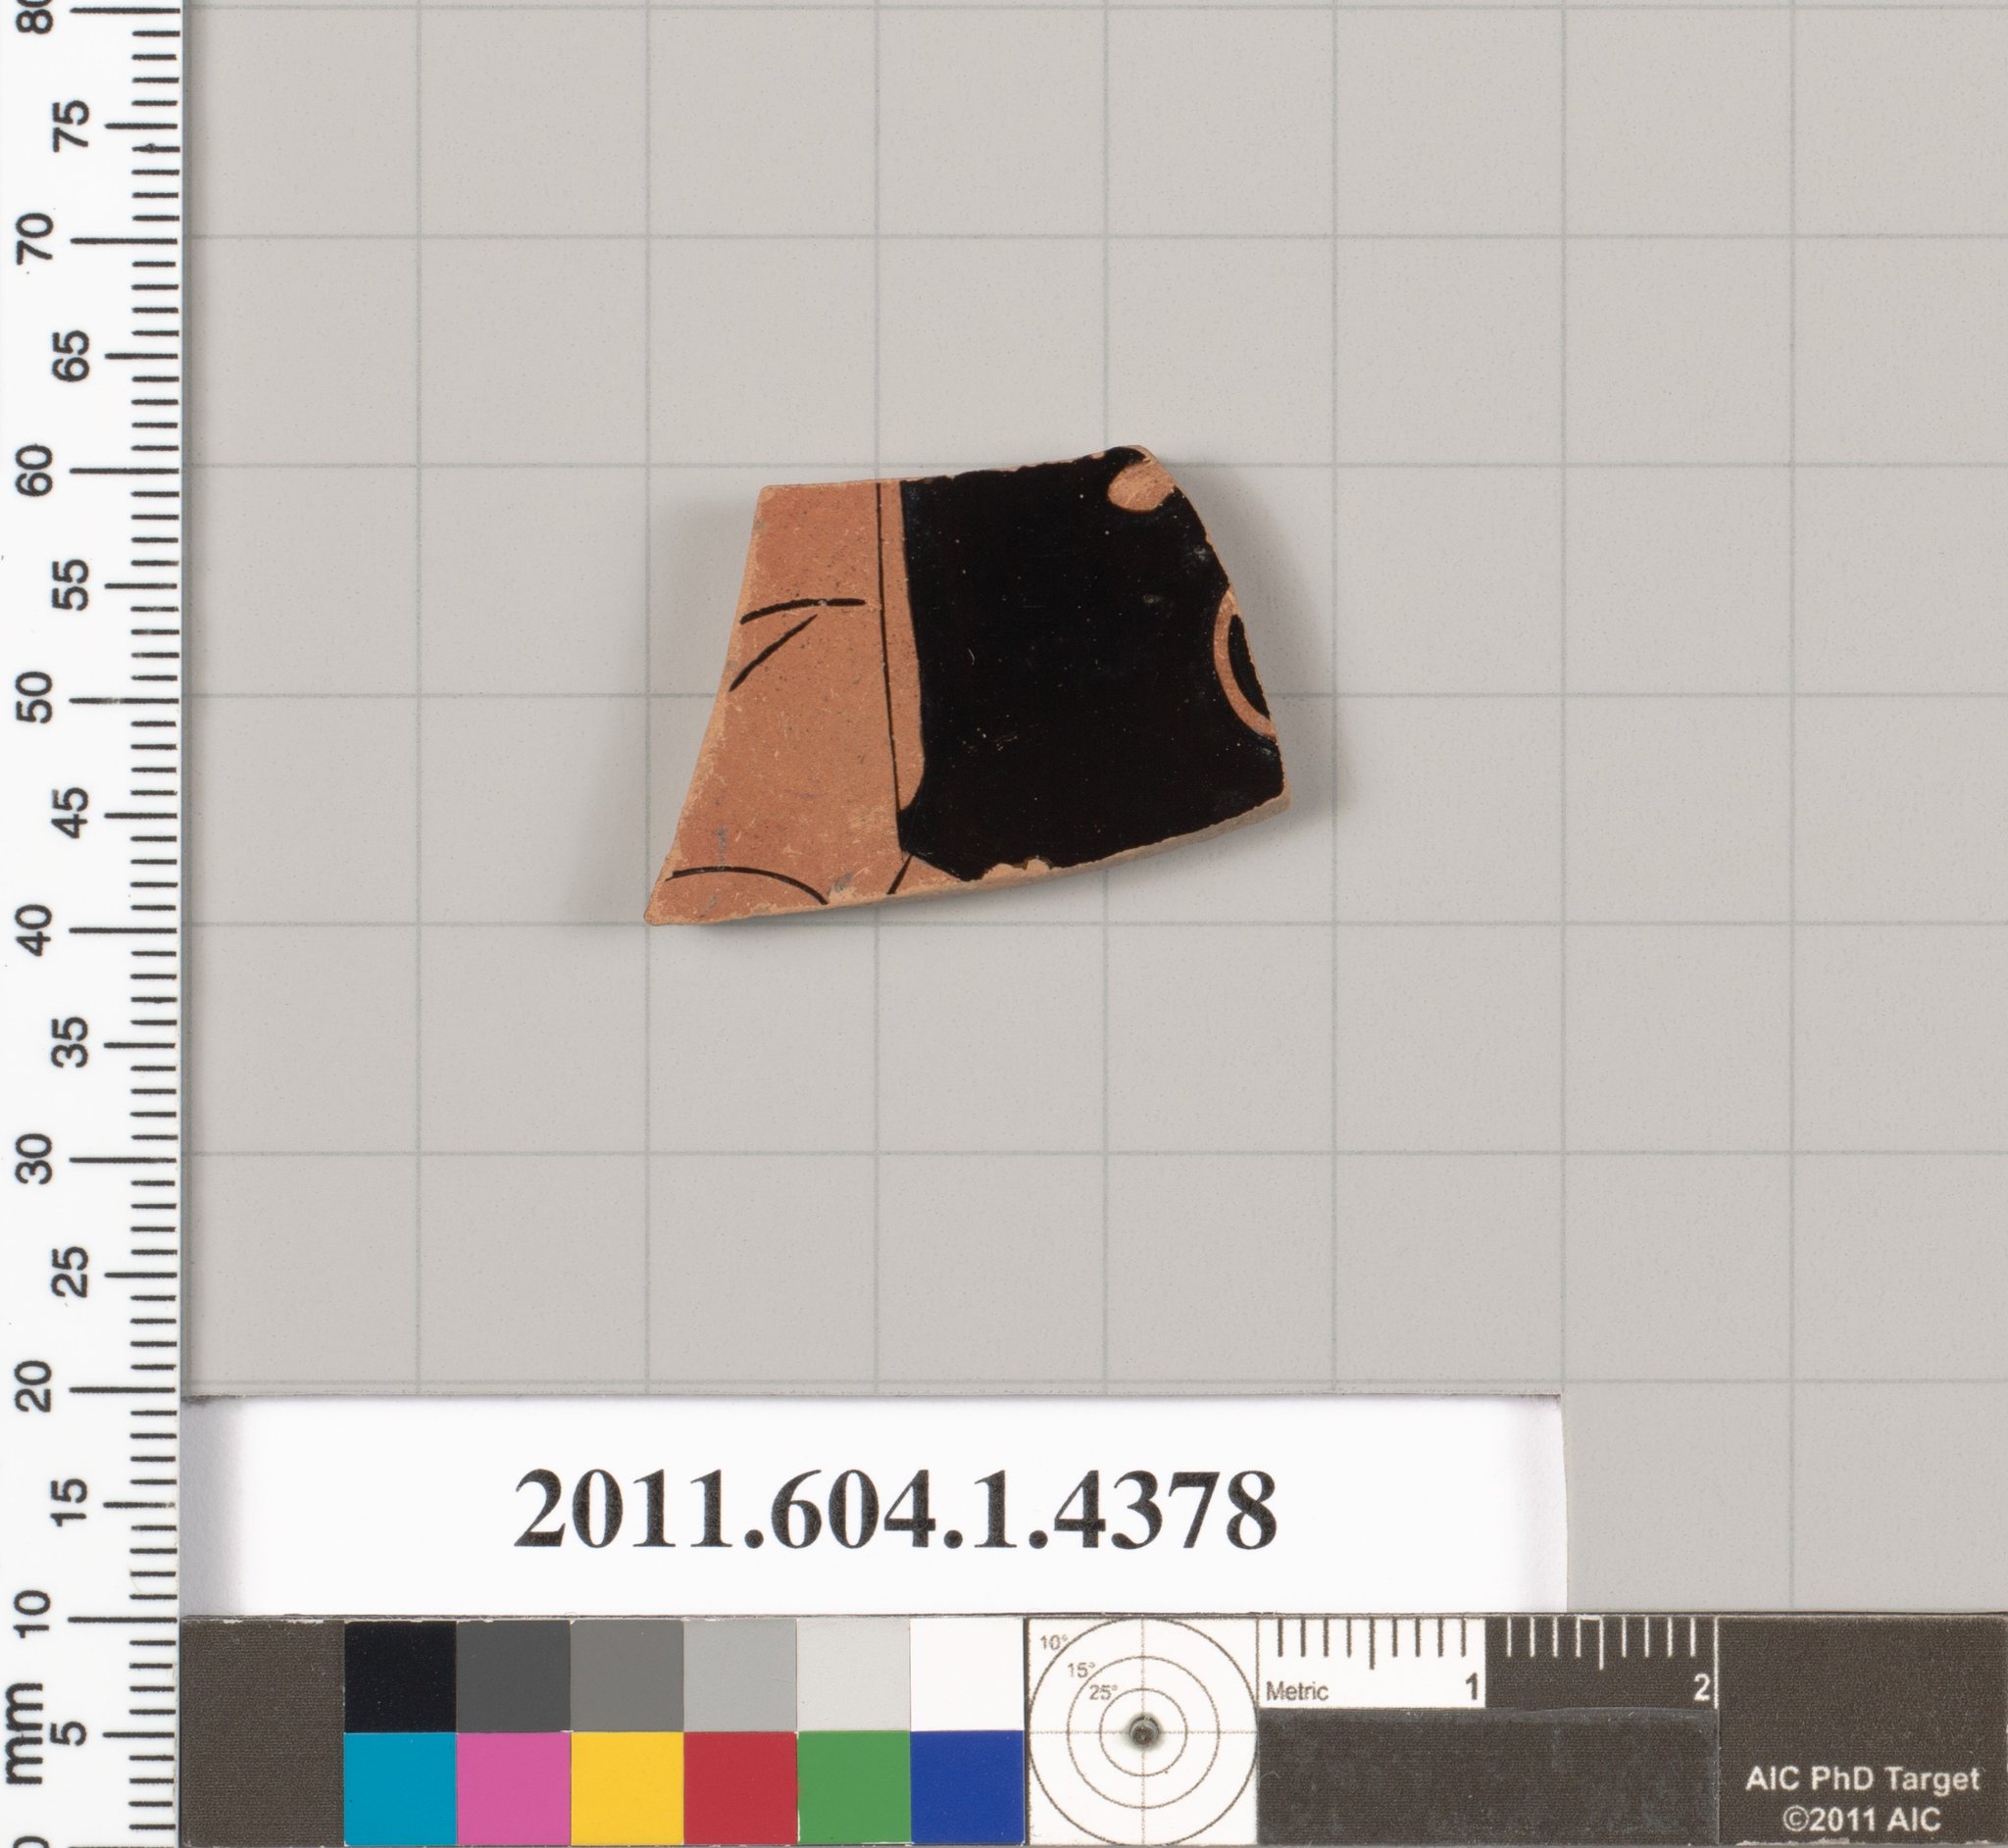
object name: kylix fragment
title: Terracotta fragment of a kylix (drinking cup)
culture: greek, attic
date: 475-451 BCE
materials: terracotta